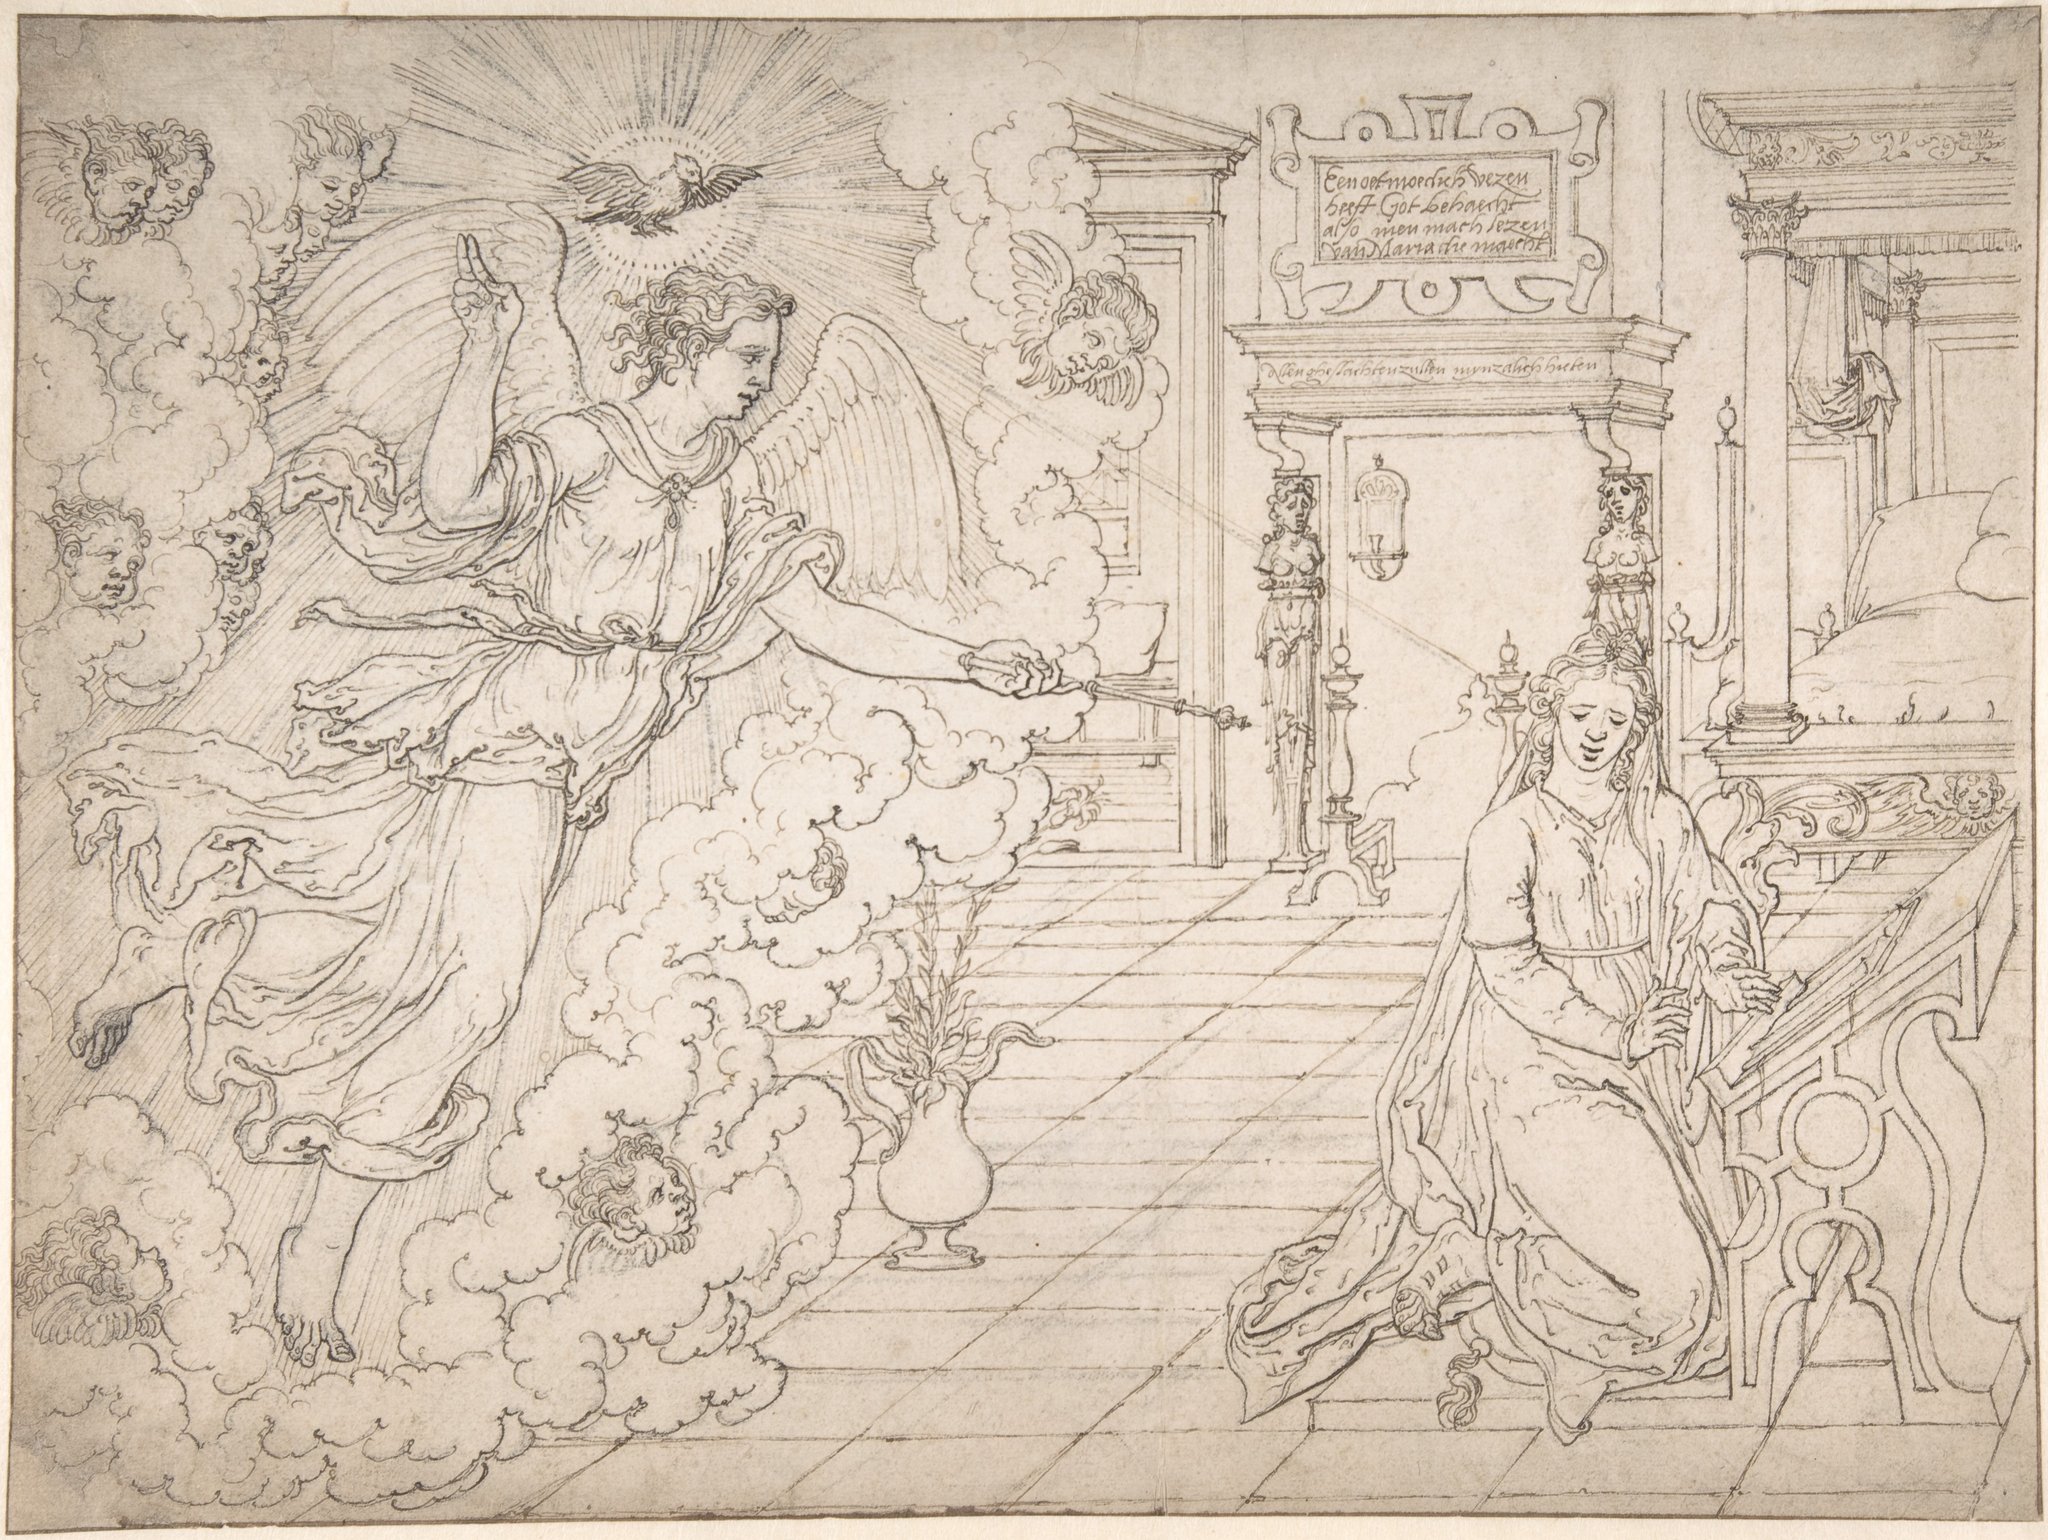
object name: drawing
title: The Annunciation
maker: dirck pietersz. crabeth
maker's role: artist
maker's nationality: netherlandish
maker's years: 1501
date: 1501-1600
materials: chalk, ink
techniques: pen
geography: netherlands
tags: bedrooms,angels,virgin mary,archangel gabriel,annunciation